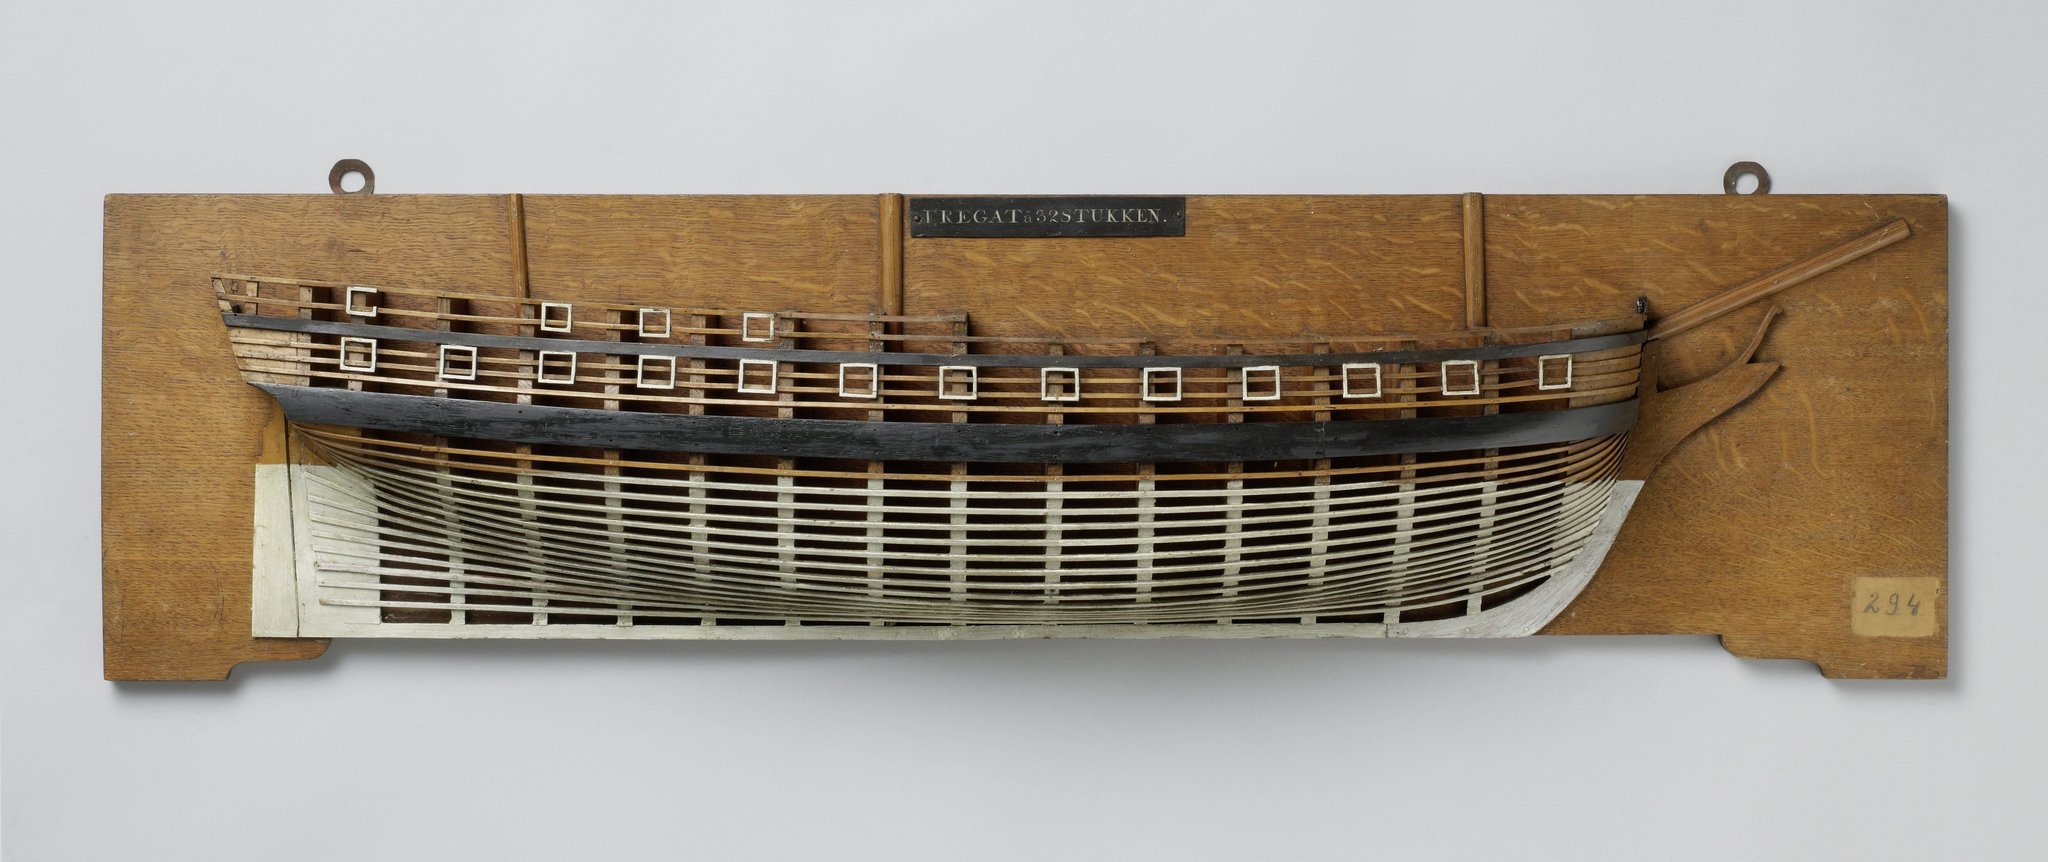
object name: ship model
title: Half Model of a 32-Gun Frigate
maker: Anonymous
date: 1780-1825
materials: wood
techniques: polychromy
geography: netherlands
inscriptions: inscription, top centre, on a square black metal label: ‘FREGAT à 32 STUKKEN.’, label, bottom right: ‘294’ former inventory label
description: Gepolychromeerd mallenmodel (stuurboord) van een driemaster. Zeventien geschutpoorten verdeeld over geschutdek en halfdek. Gewrongen spiegel, hol wulf, geen details van hek of zijgalerij; recht roer met vierkante roerkoning. Zeeg aan beide uiteinden iets oplopend, één berghout en één reehout. Gepiekt rondspant.